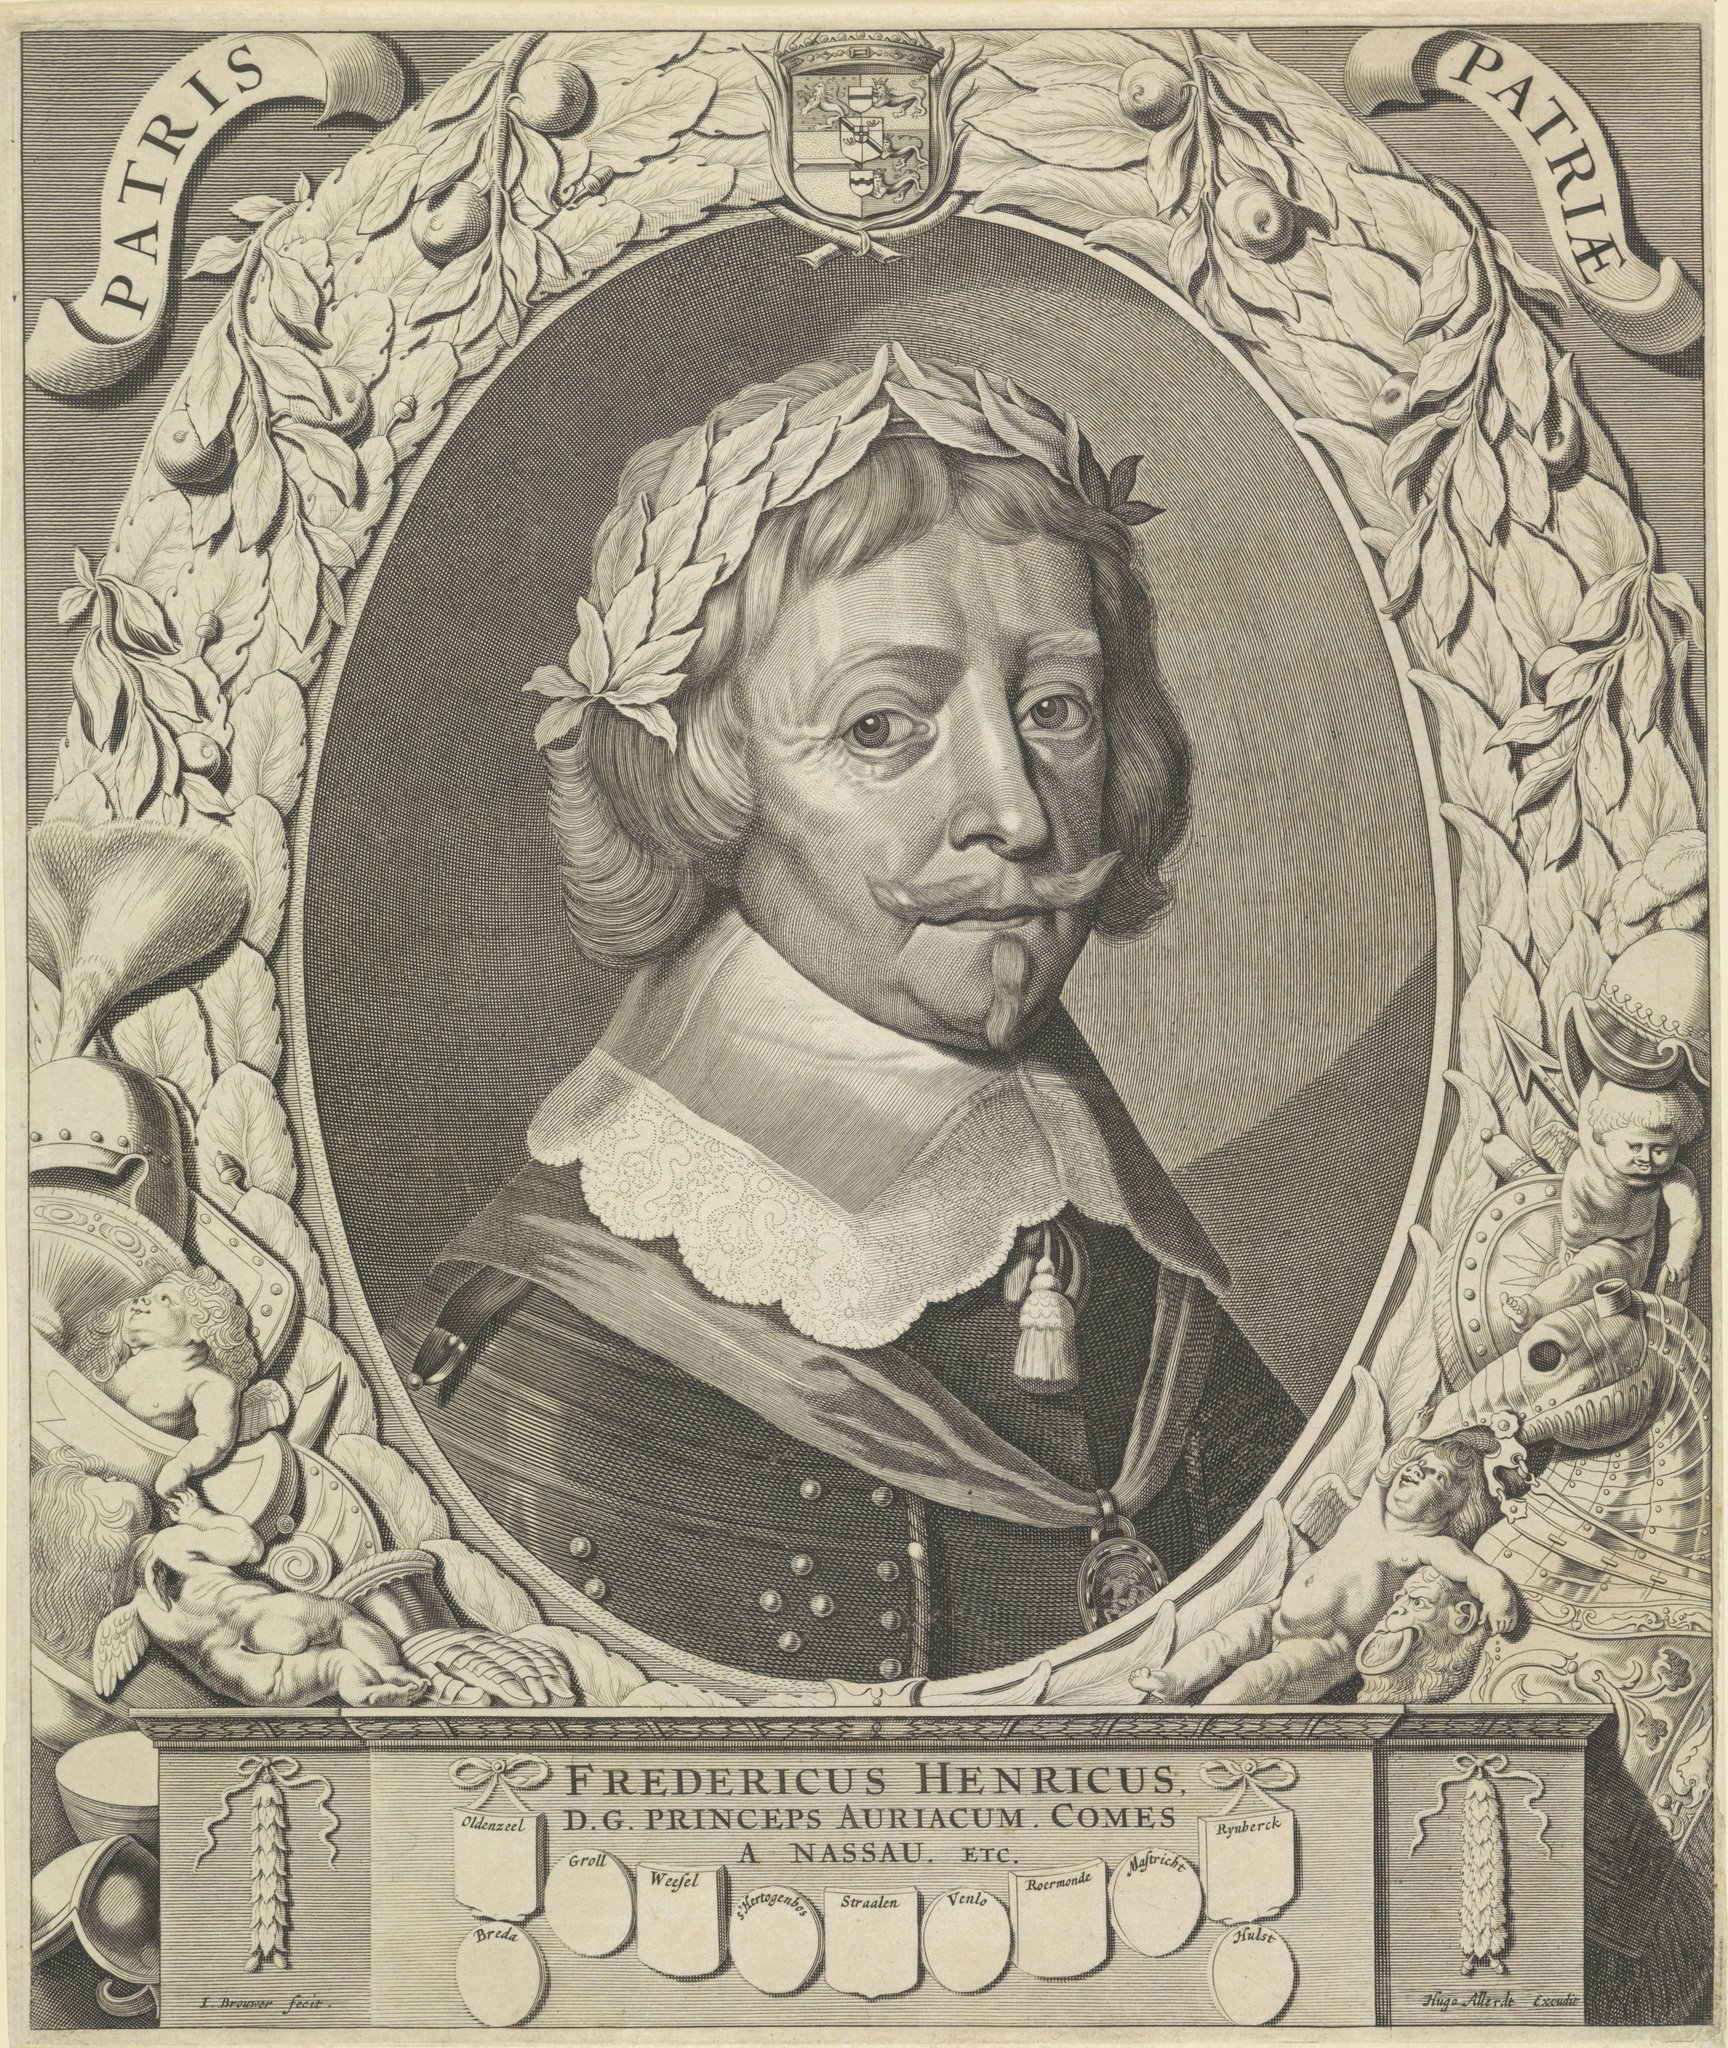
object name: print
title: Portret van Frederik Hendrik, prins van Oranje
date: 1645-1684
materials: paper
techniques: engraving, etching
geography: amsterdam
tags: delft, the hague, frederick henry (prince of orange), knighthood order (garter) - insignia of a knighthood order, e.g.: badge, chain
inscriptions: collector's mark: Lugt 963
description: Portret van Frederik Hendrik met een lauwerkrans in een ovaal van lauwerbladen met een aantal allegorische figuren en objecten. Midden boven zijn wapen met een kroon. Op een voetstuk zijn naam en elf blanco stedewapens. Op twee banderollen zijn lijfspreuk.